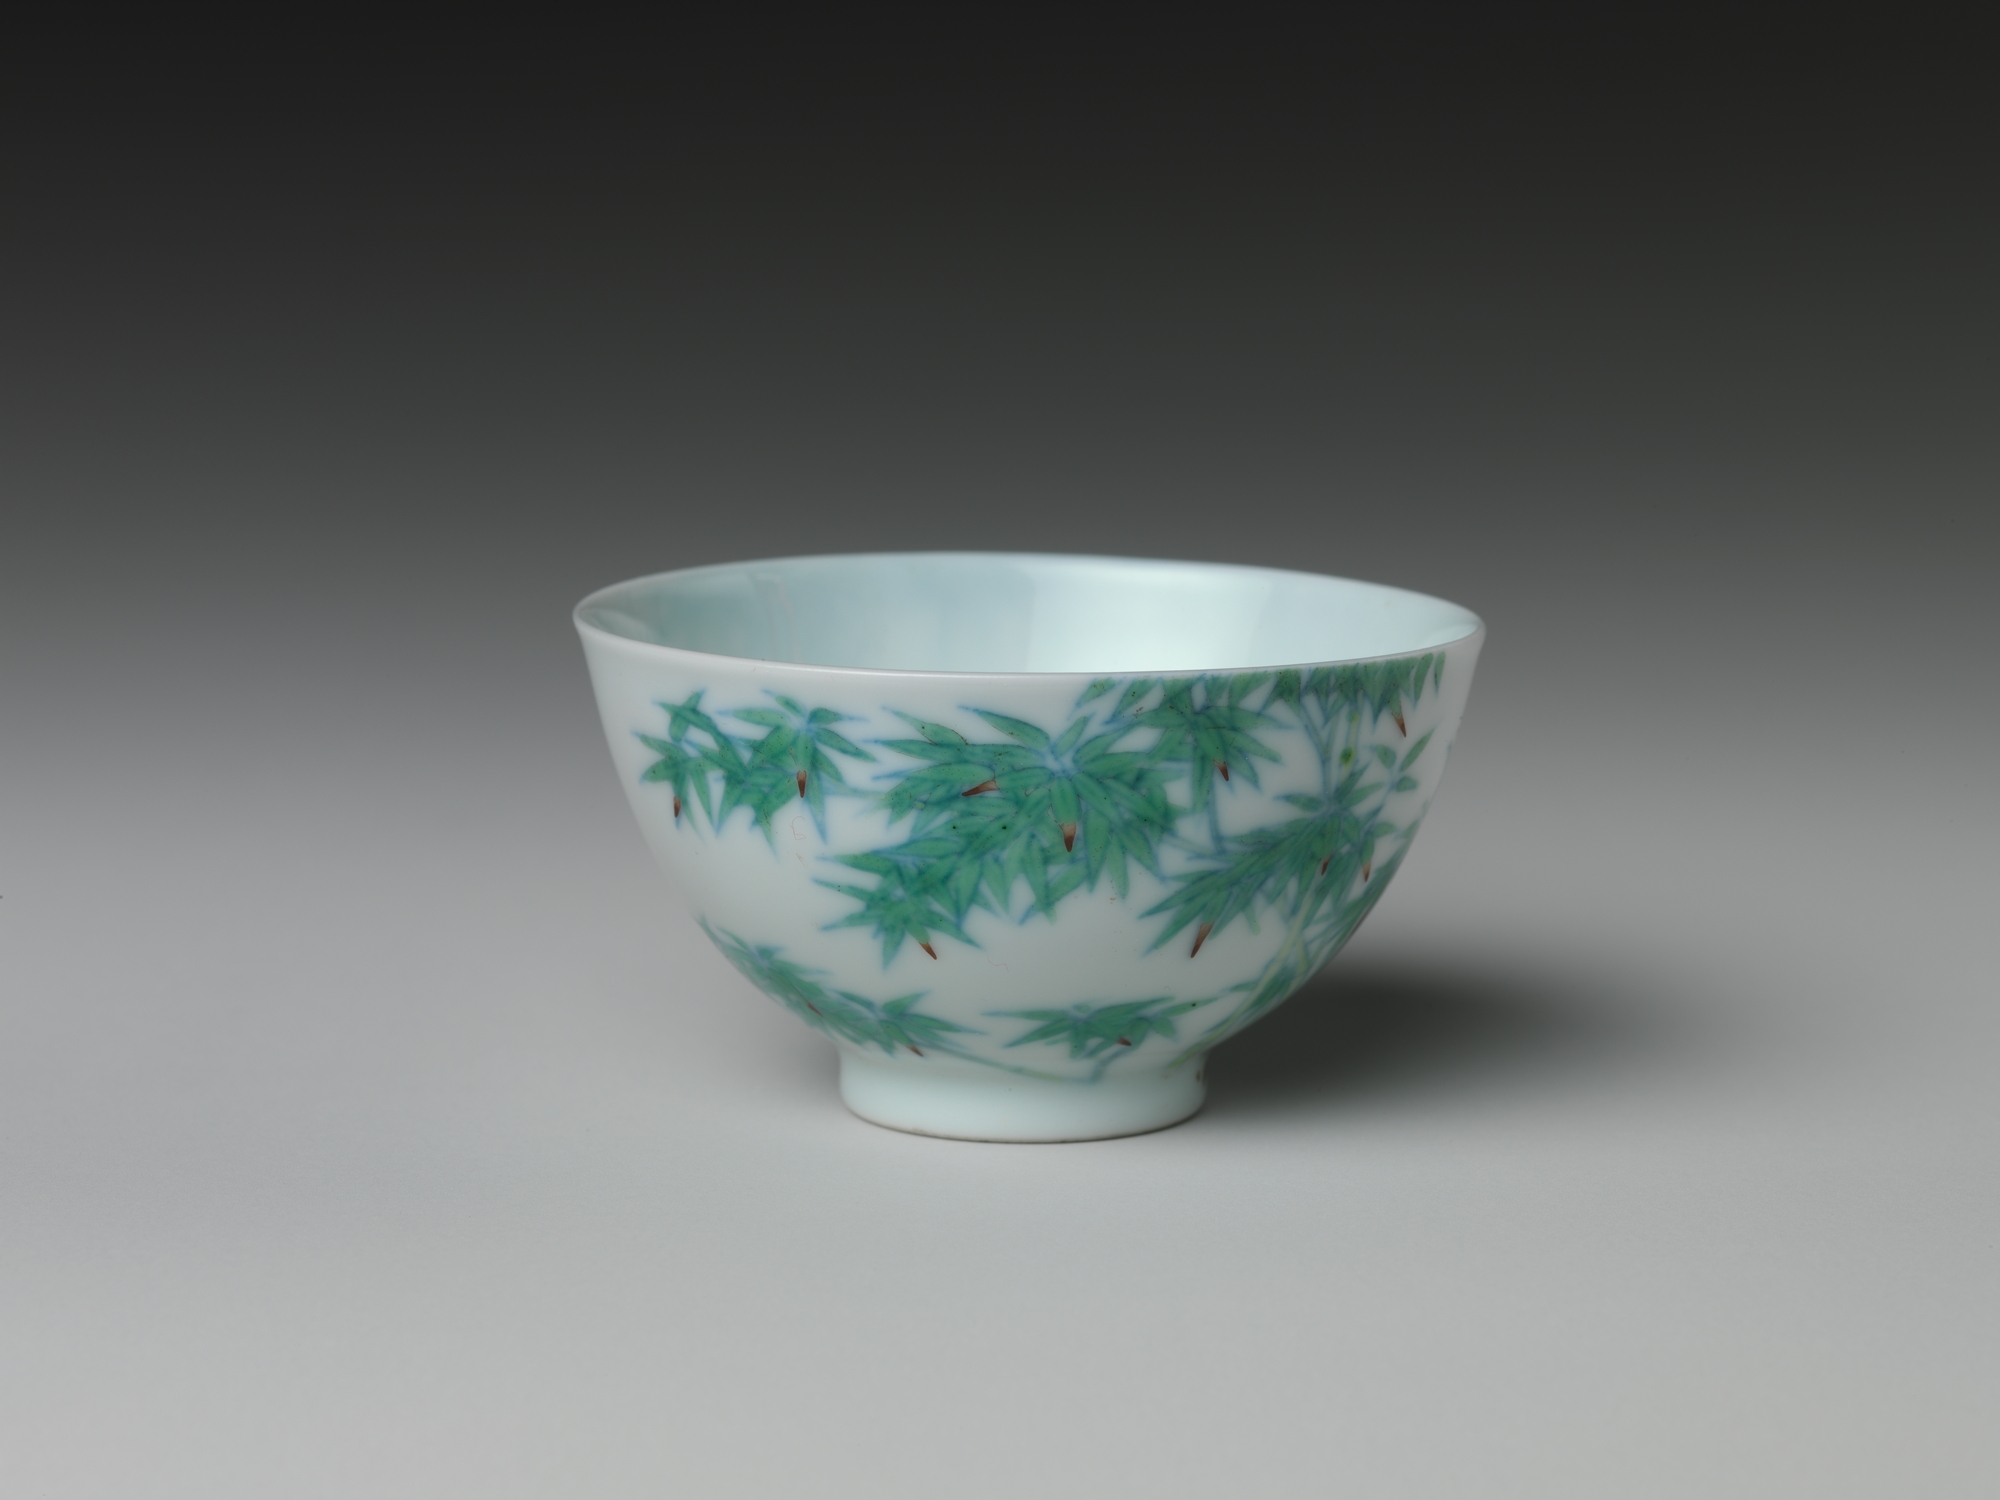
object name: cup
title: Wine Cup with Bamboo (one of a pair)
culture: chinese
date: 1701-1733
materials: cobalt, enamel, glaze, porcelain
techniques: painting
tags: bamboo